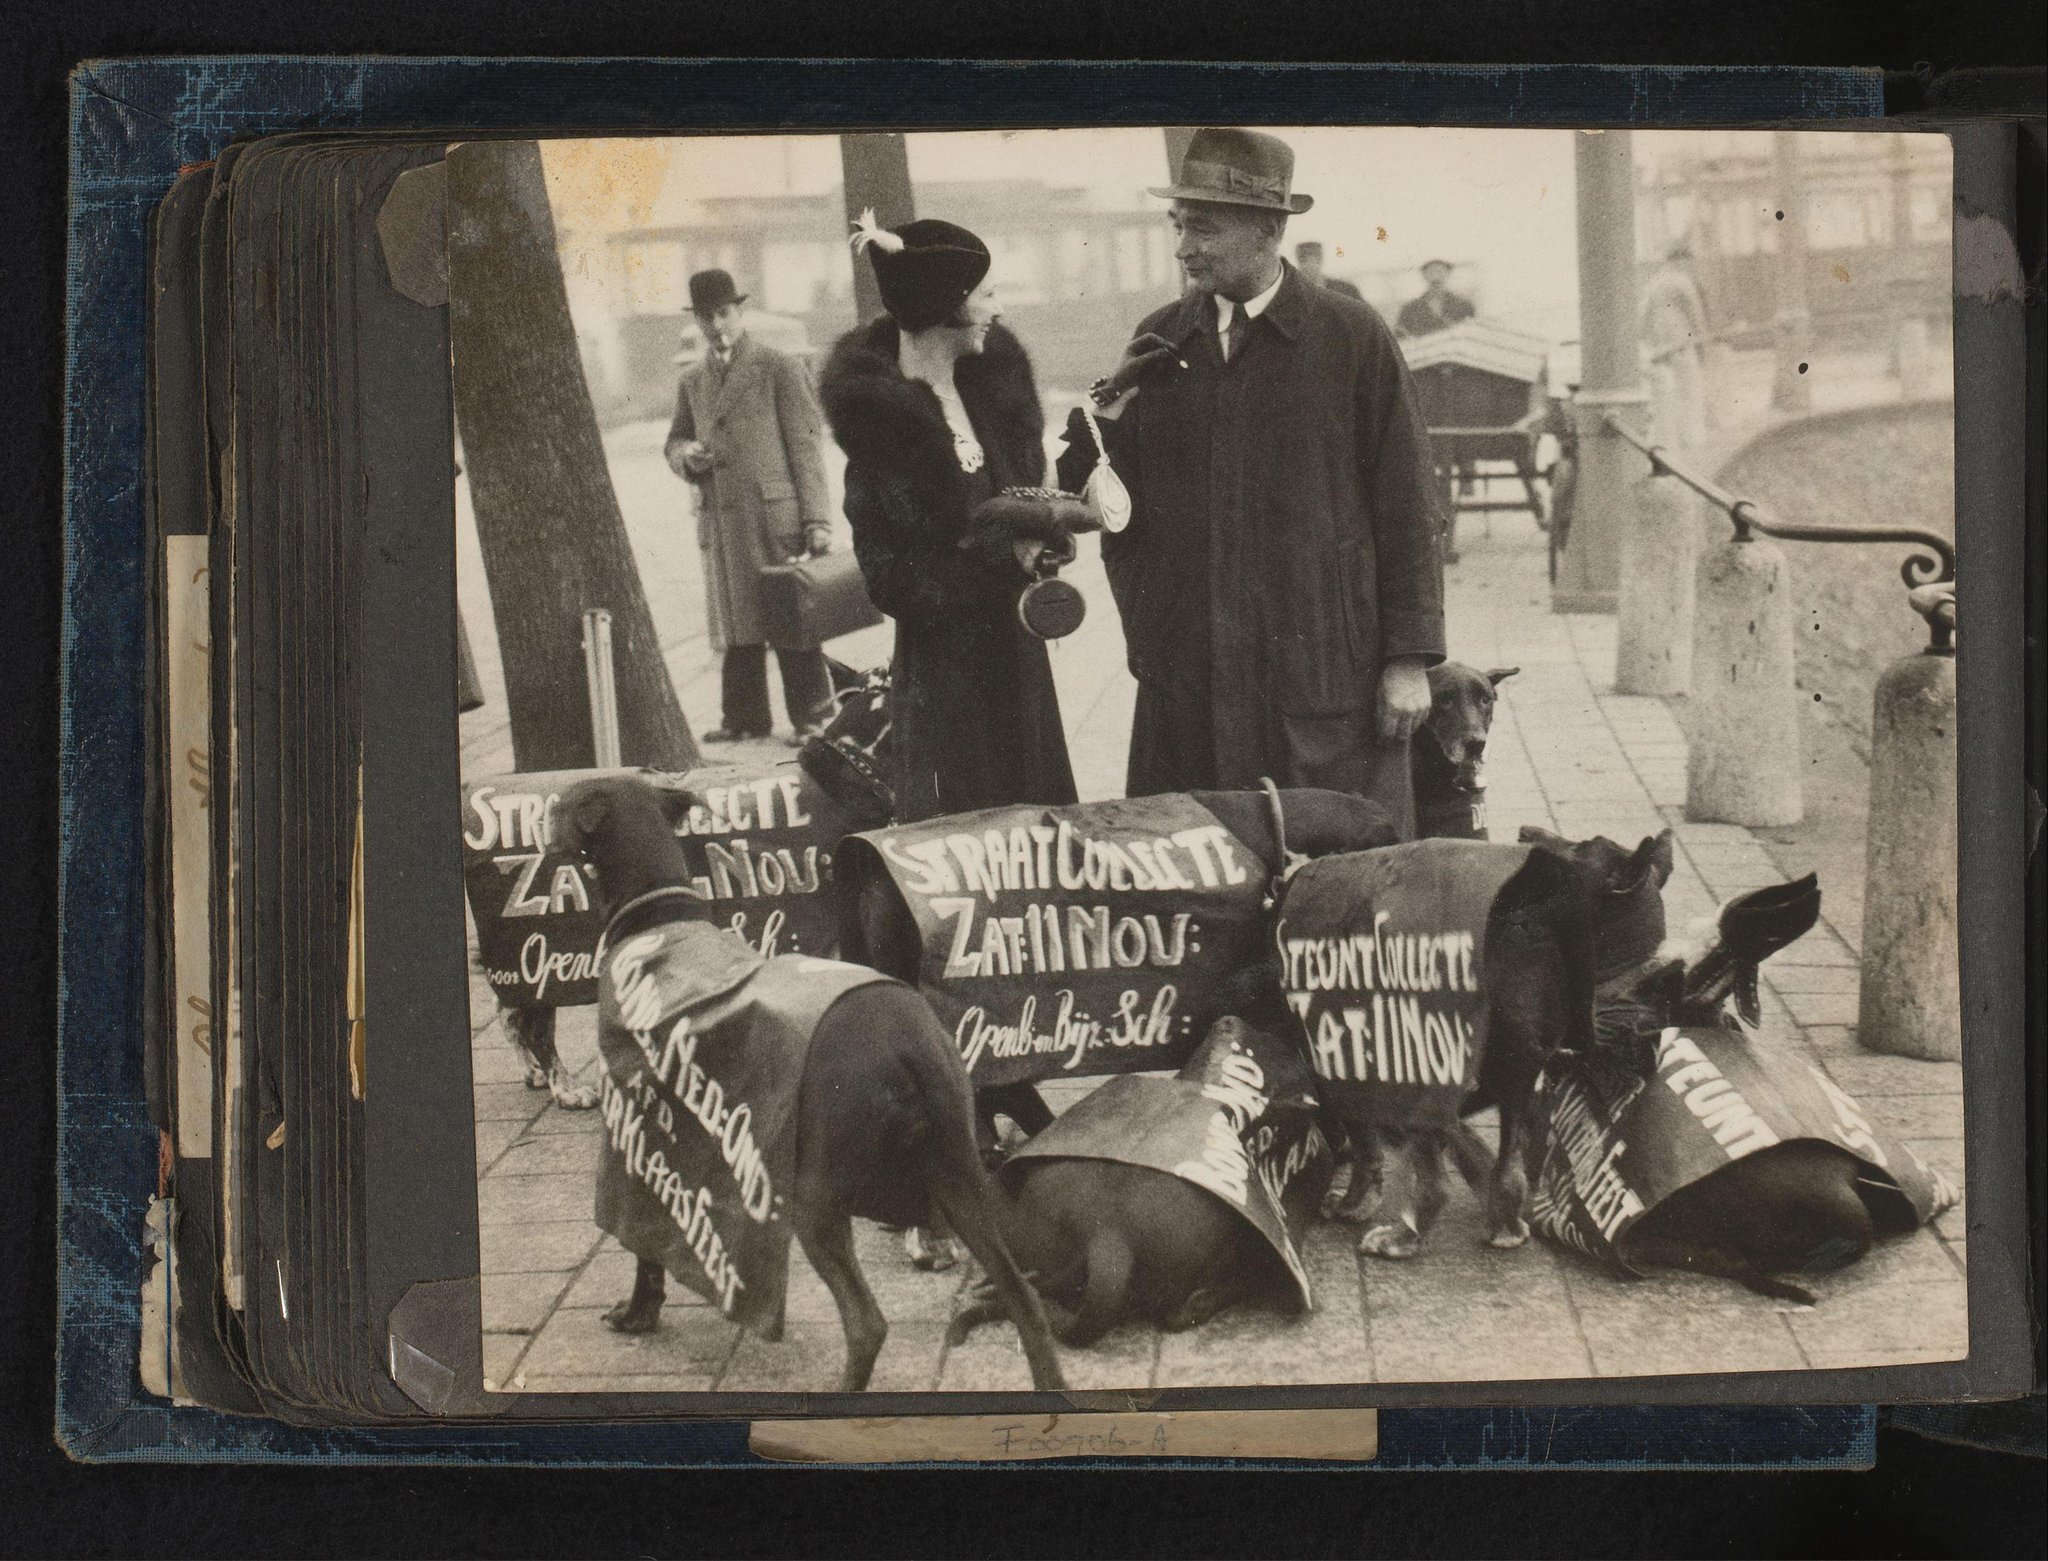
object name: album leaf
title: Doppendokter met honden met reclameteksten voor de straatcollecte van 11 november op de rug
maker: Anonymous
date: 1930-1940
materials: photographic support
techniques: gelatin silver print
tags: adult woman, advertising, adult man, dog